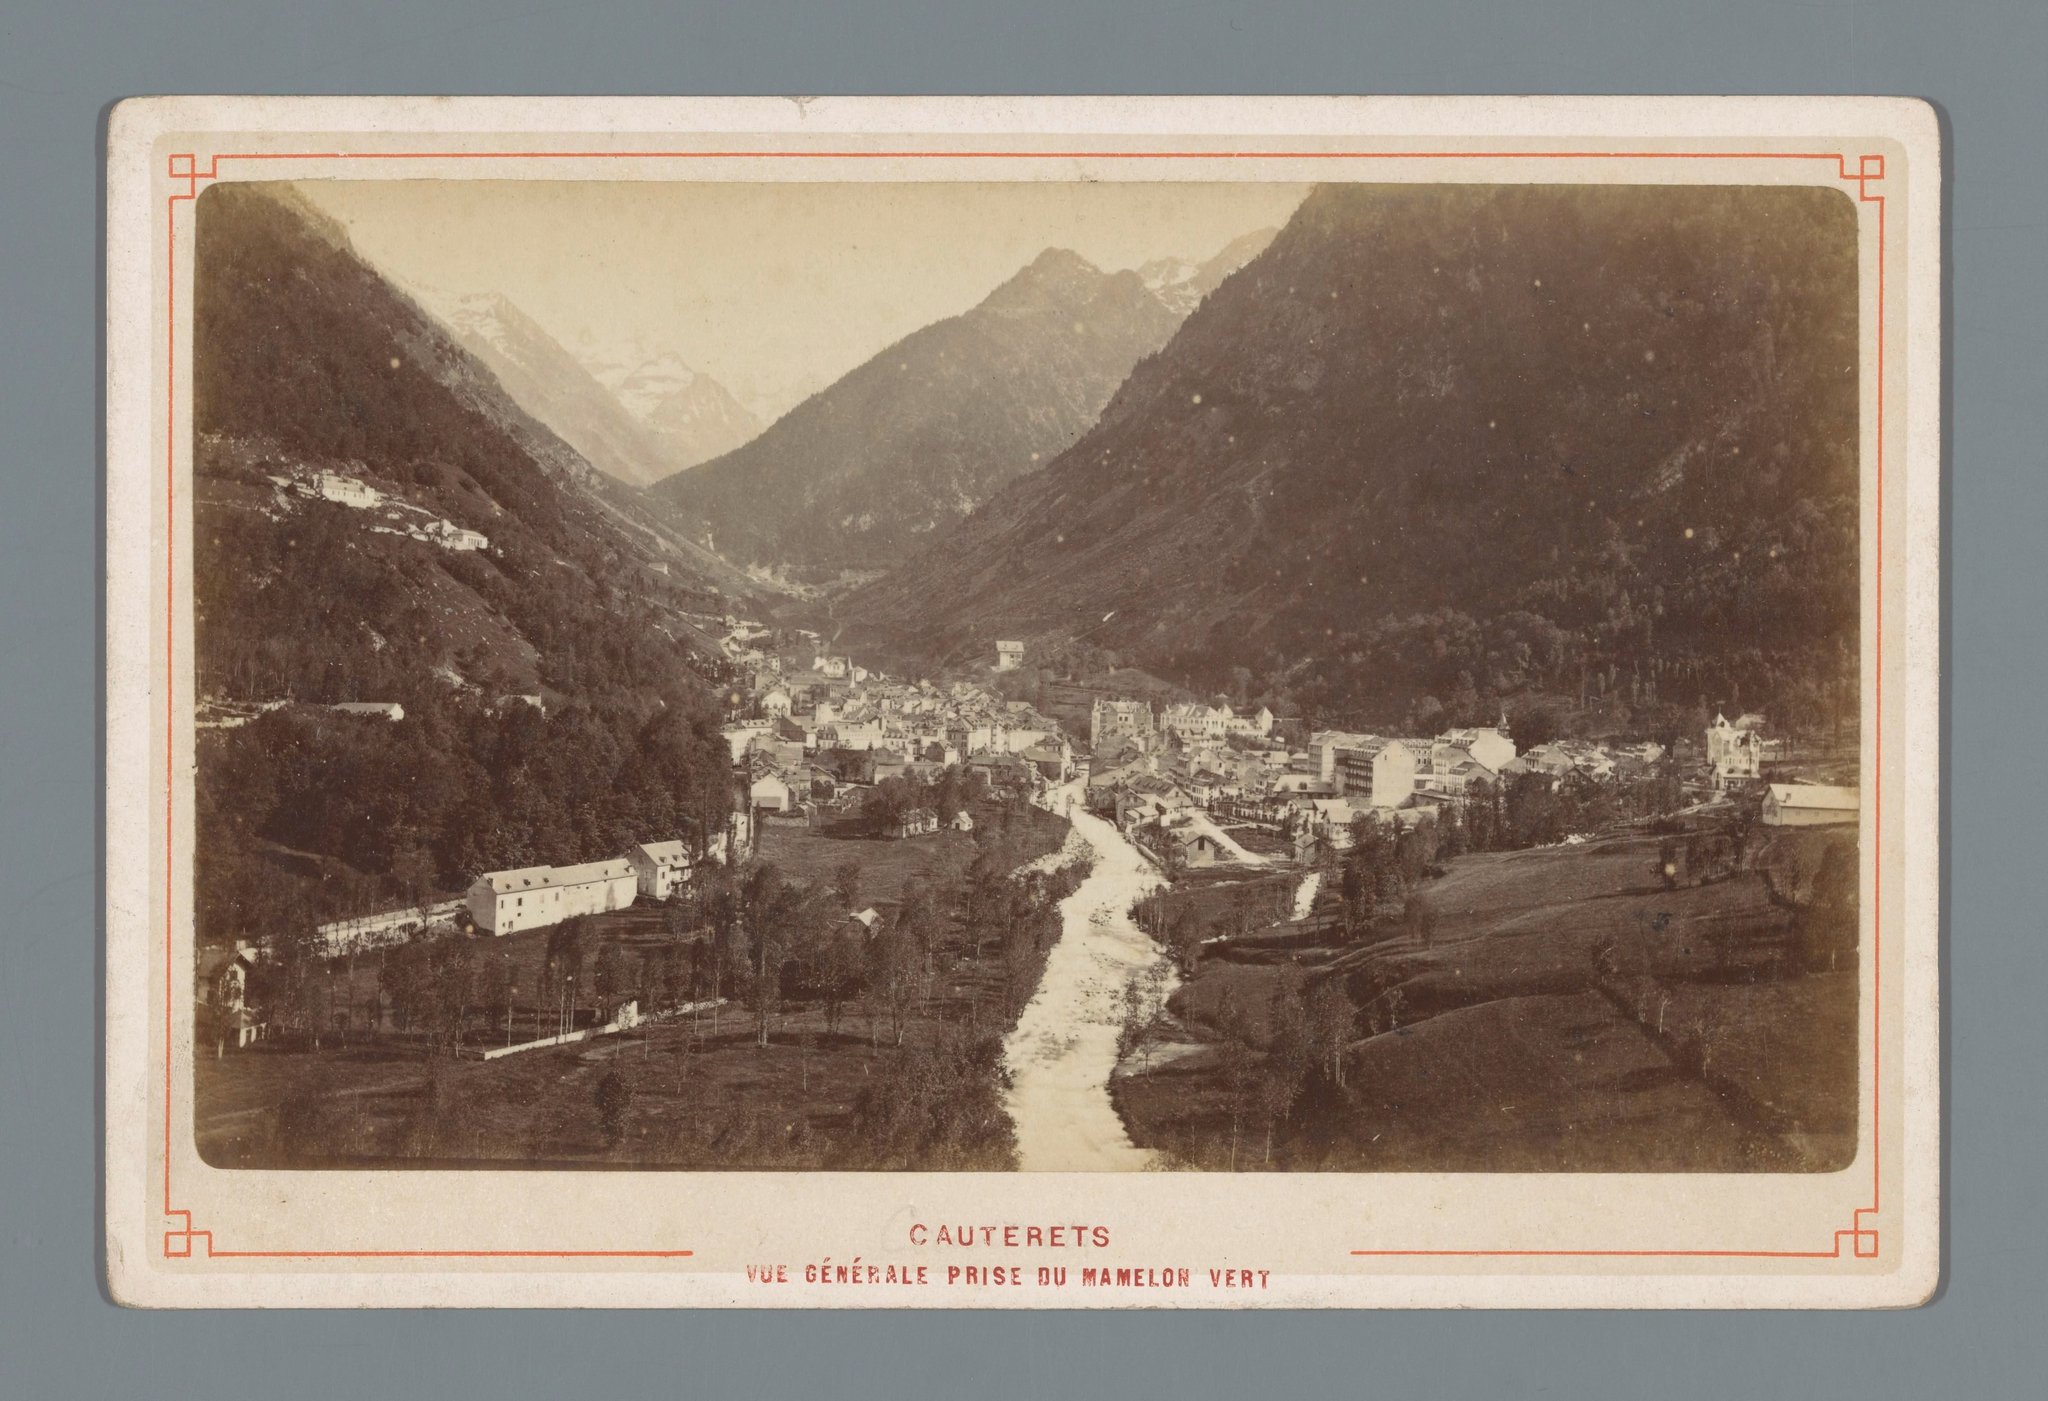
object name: photograph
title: Vue générale prise du Mamelon Vert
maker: Anonymous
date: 1850-1900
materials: cardboard, photographic support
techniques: albumen print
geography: cauterets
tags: city-view in general; 'veduta', mountains